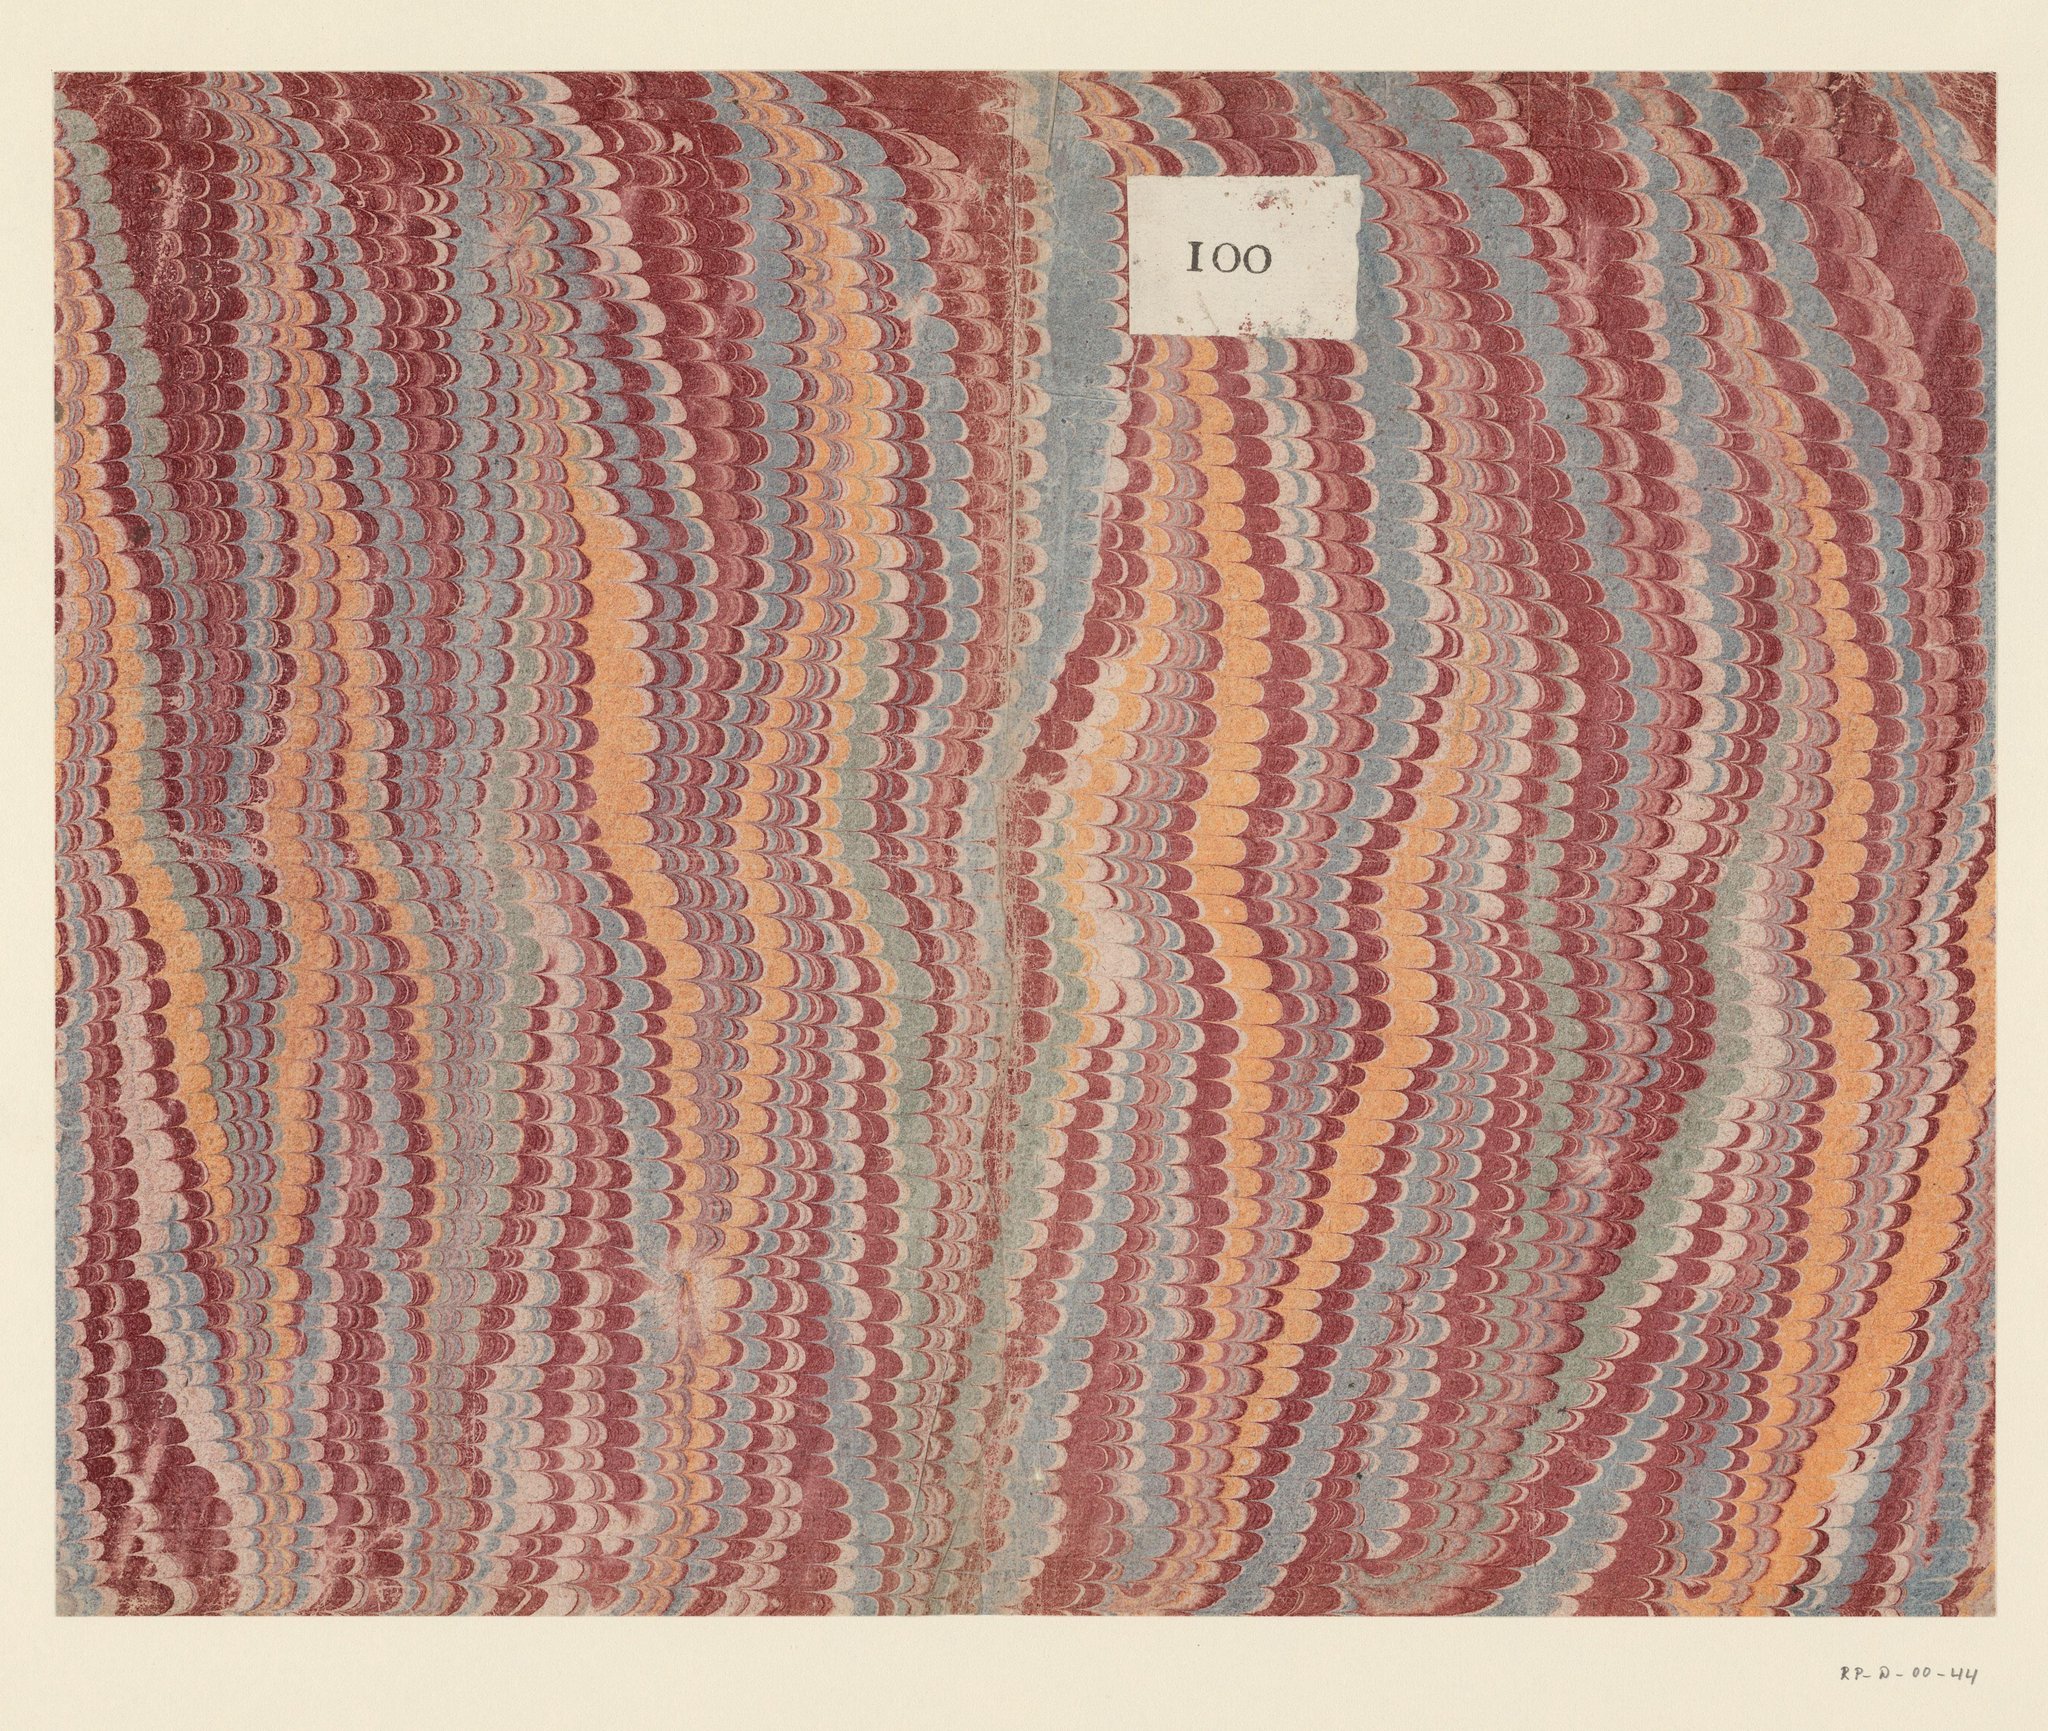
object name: marbled paper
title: Kammarmer in rood, geel, blauw en groen met etiket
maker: Anonymous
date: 1700-1850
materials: paint, paper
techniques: marbled paper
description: Kammarmer in rood, geel, blauw en groen. Gebruikt als omslag met opgeplakt etiket met opdruk: 100.